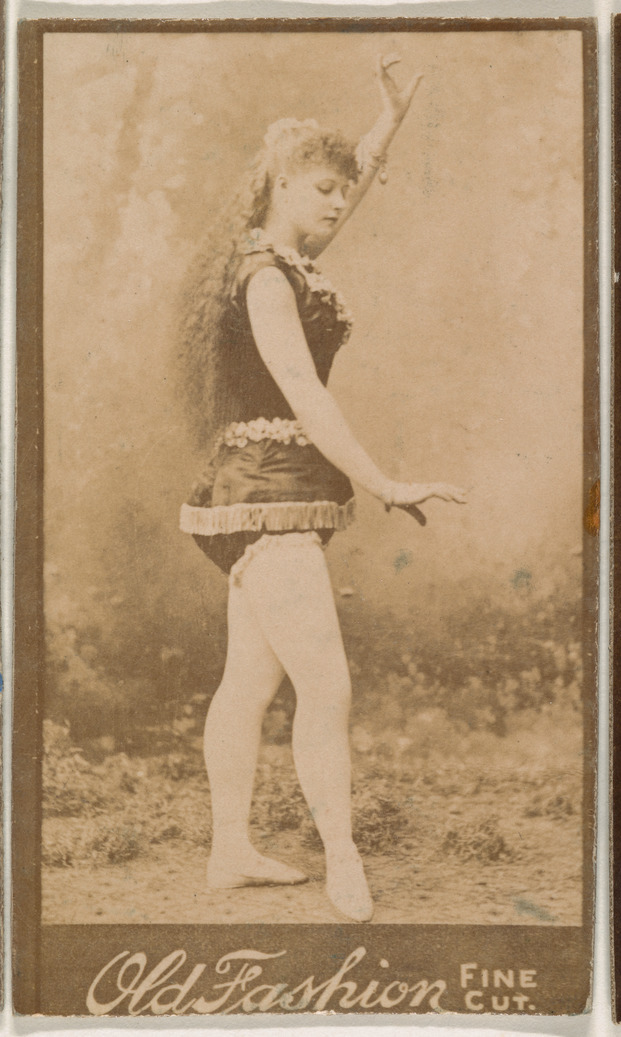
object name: photograph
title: Actress posing with one arm aloft, from the Actresses series (N664) promoting Old Fashion Fine Cut Tobacco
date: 1888-1890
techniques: albumen silver print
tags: portraits,women,actresses